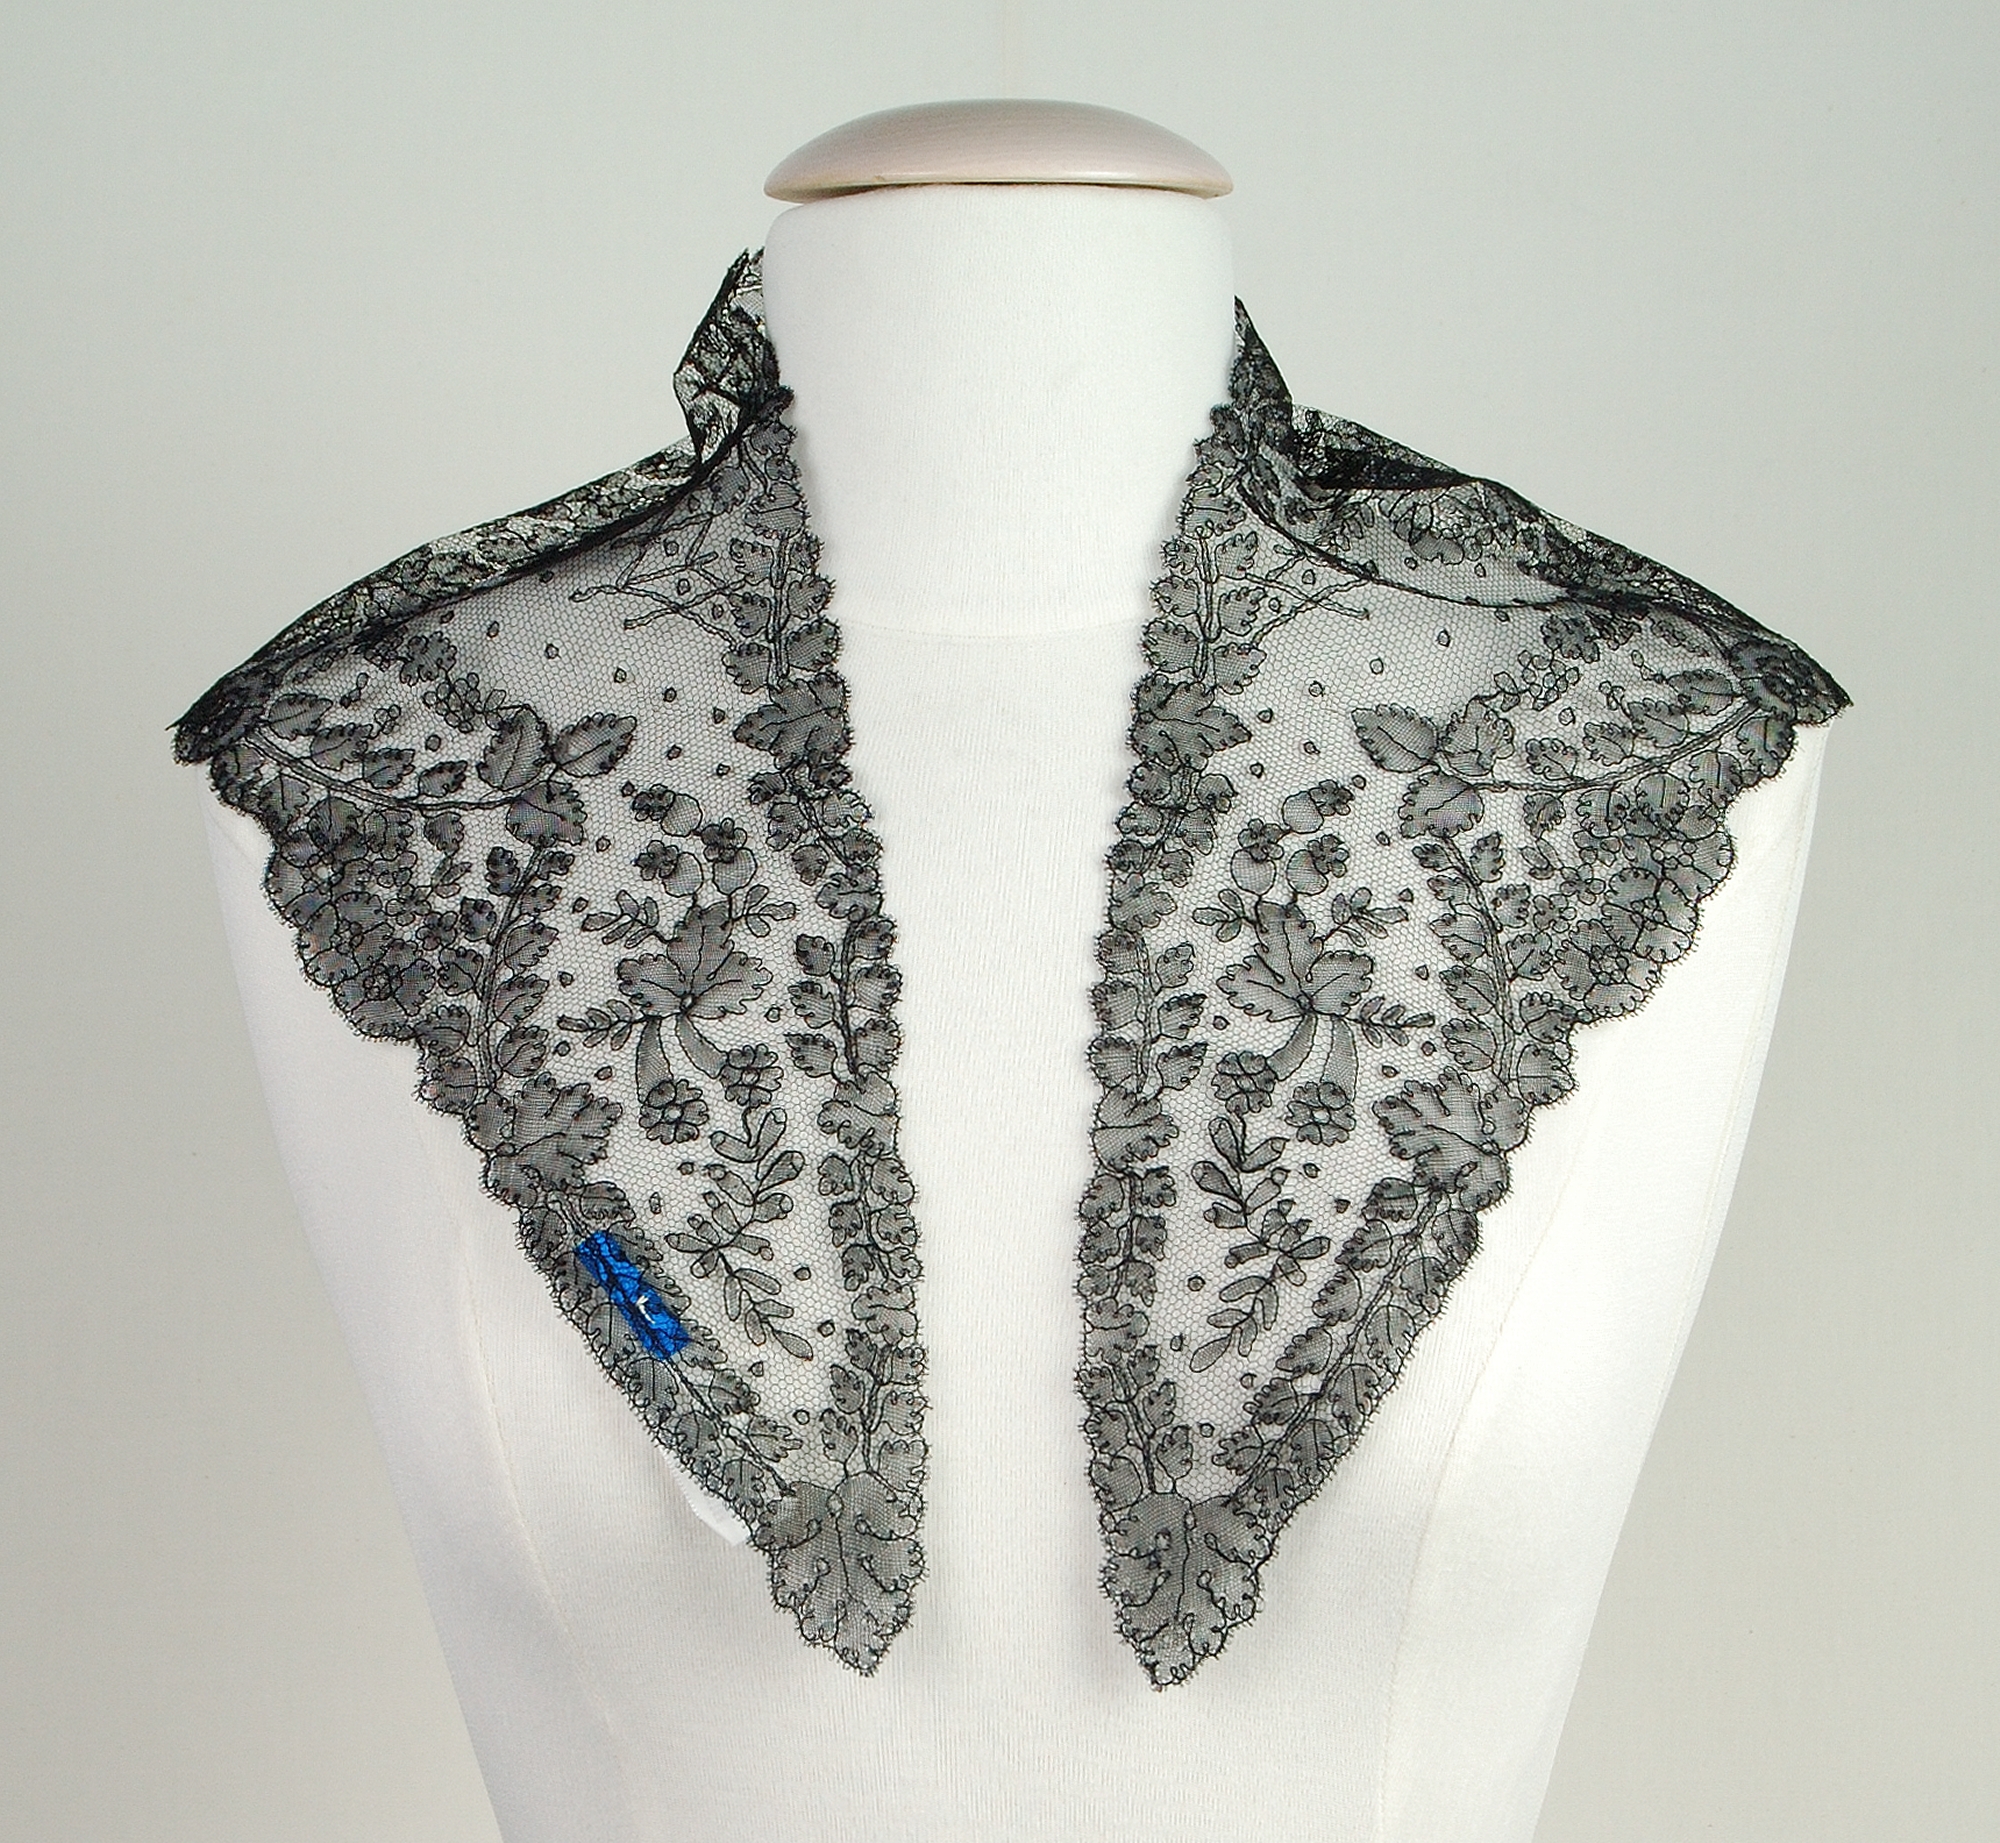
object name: fichu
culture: french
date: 1875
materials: silk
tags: flowers